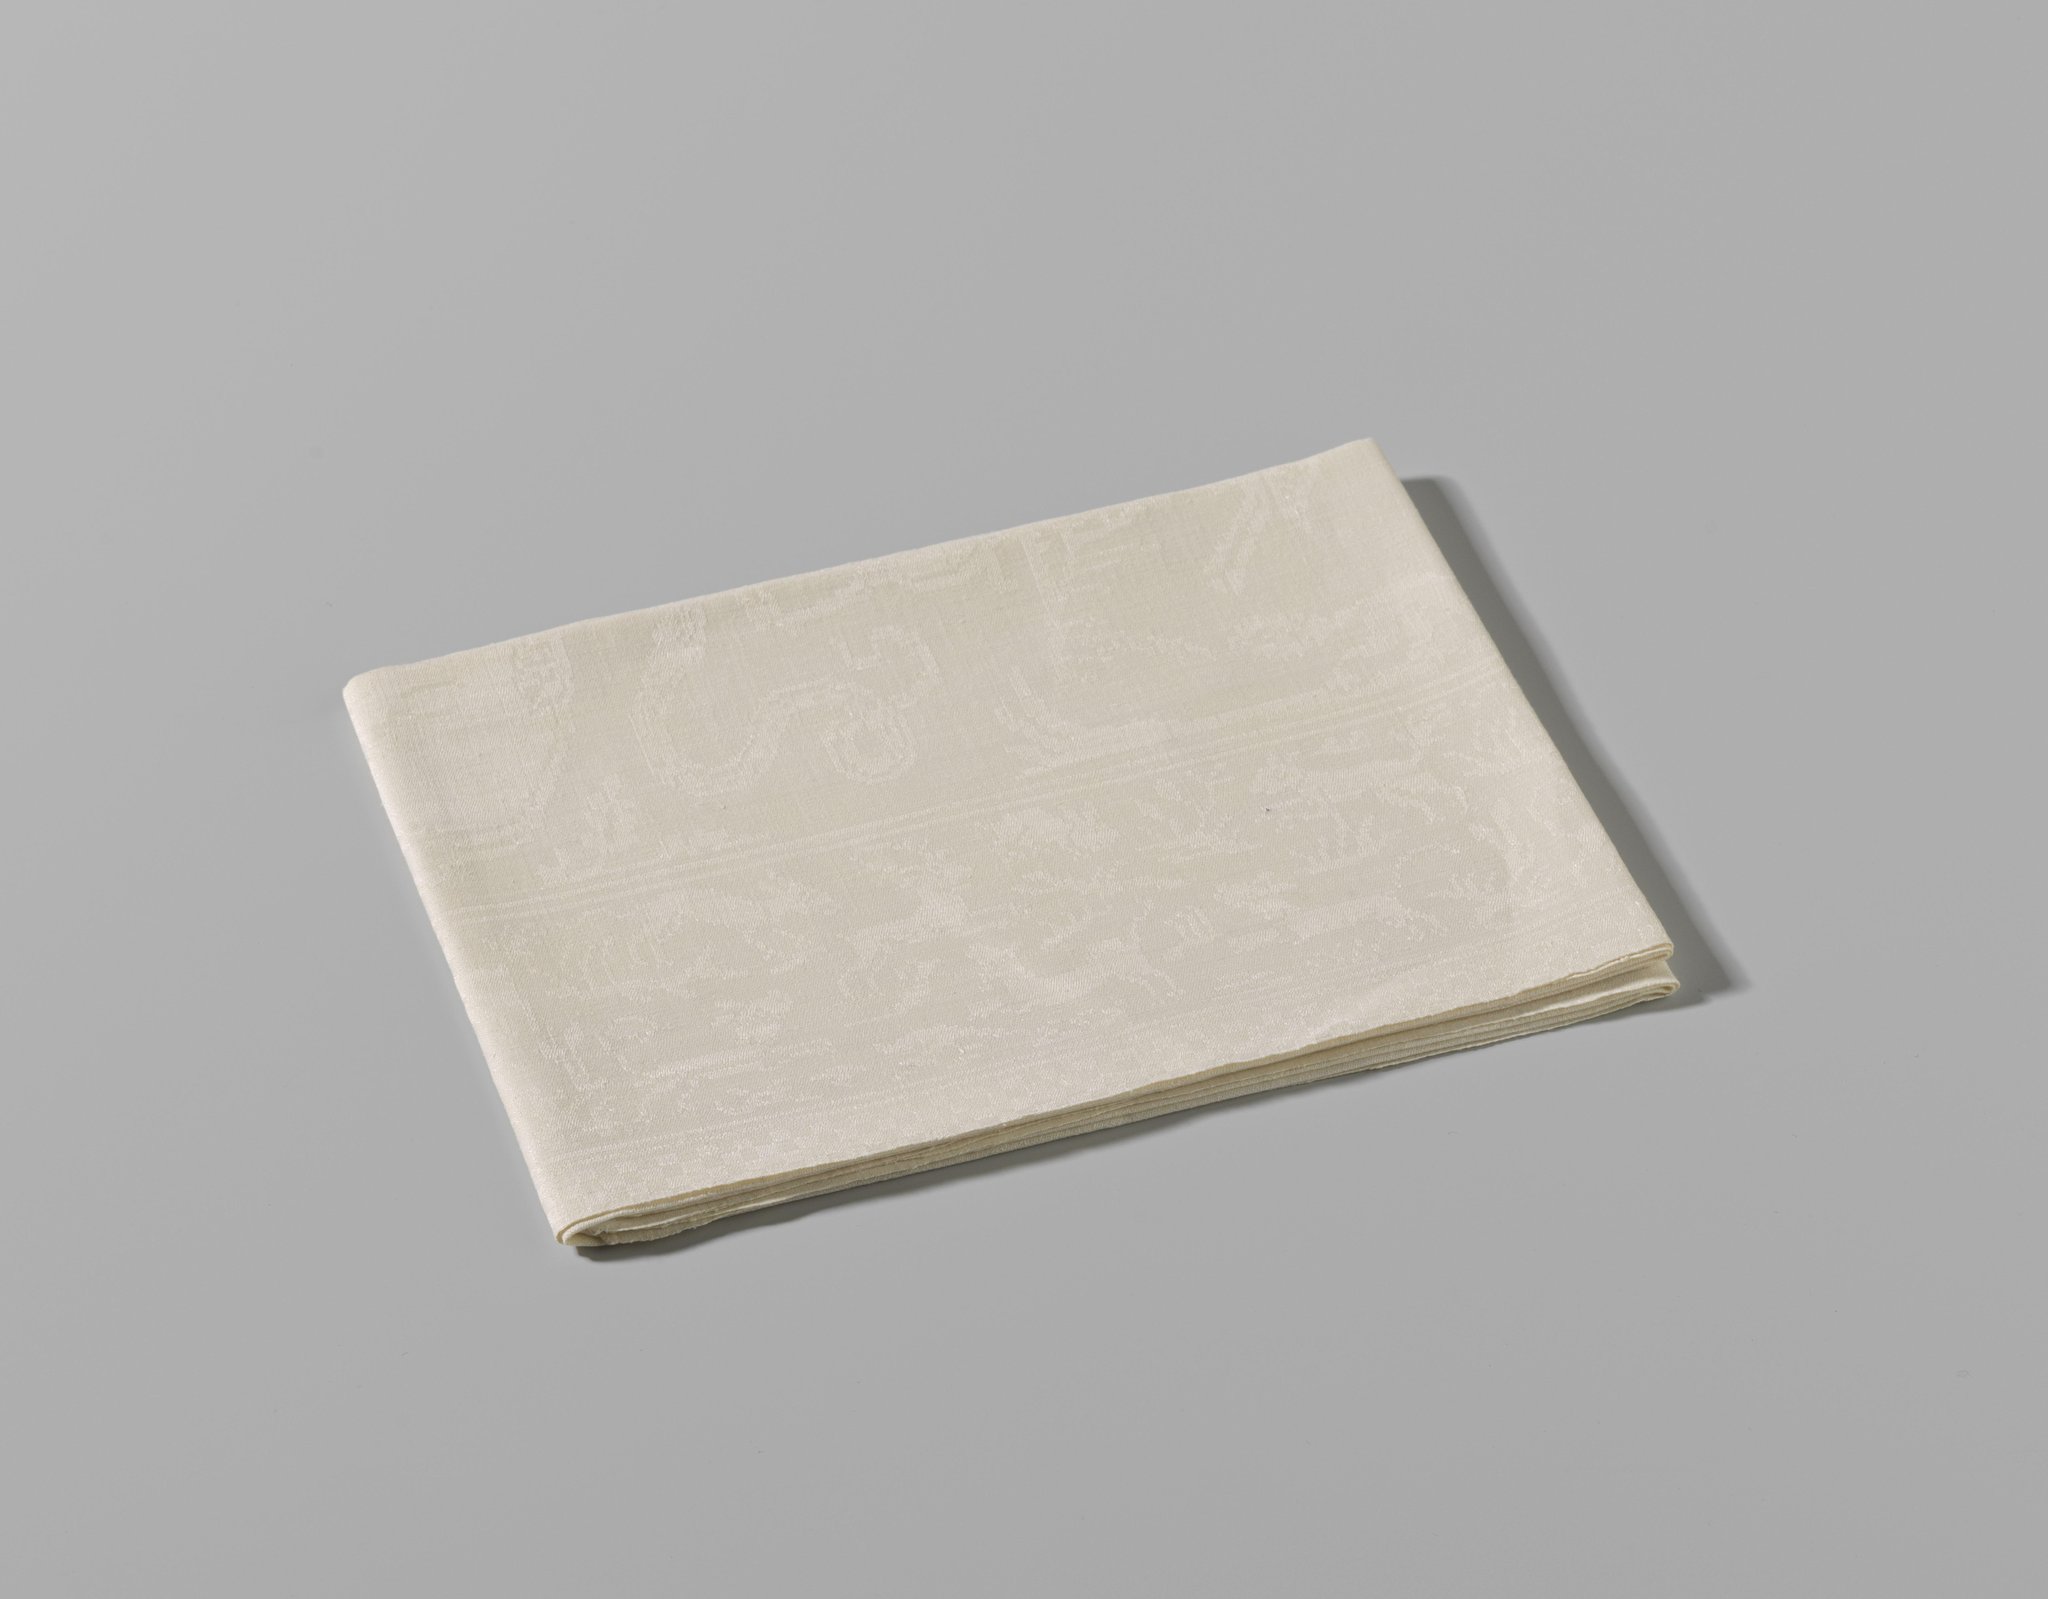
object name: napkin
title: Servet met Orpheus te midden van de dieren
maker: Anonymous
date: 1650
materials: linen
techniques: damask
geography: haarlem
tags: orpheus playing the lyre: trees and rocks move, beasts and birds are enchanted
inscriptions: mark: ‘NM 12097’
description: Servet van linnendamast met Orpheus te midden van de dieren. Middenveld: Het symmetrisch verdubbeld patroon vertoont Orpheus gezeten te midden van de dieren. Staande randen: honden die op een hert en een haas jagen. Liggende randen: jager met hoorn, speer en hond die jaagt op een hert en een haas. Hoeken: een jager met een hond.